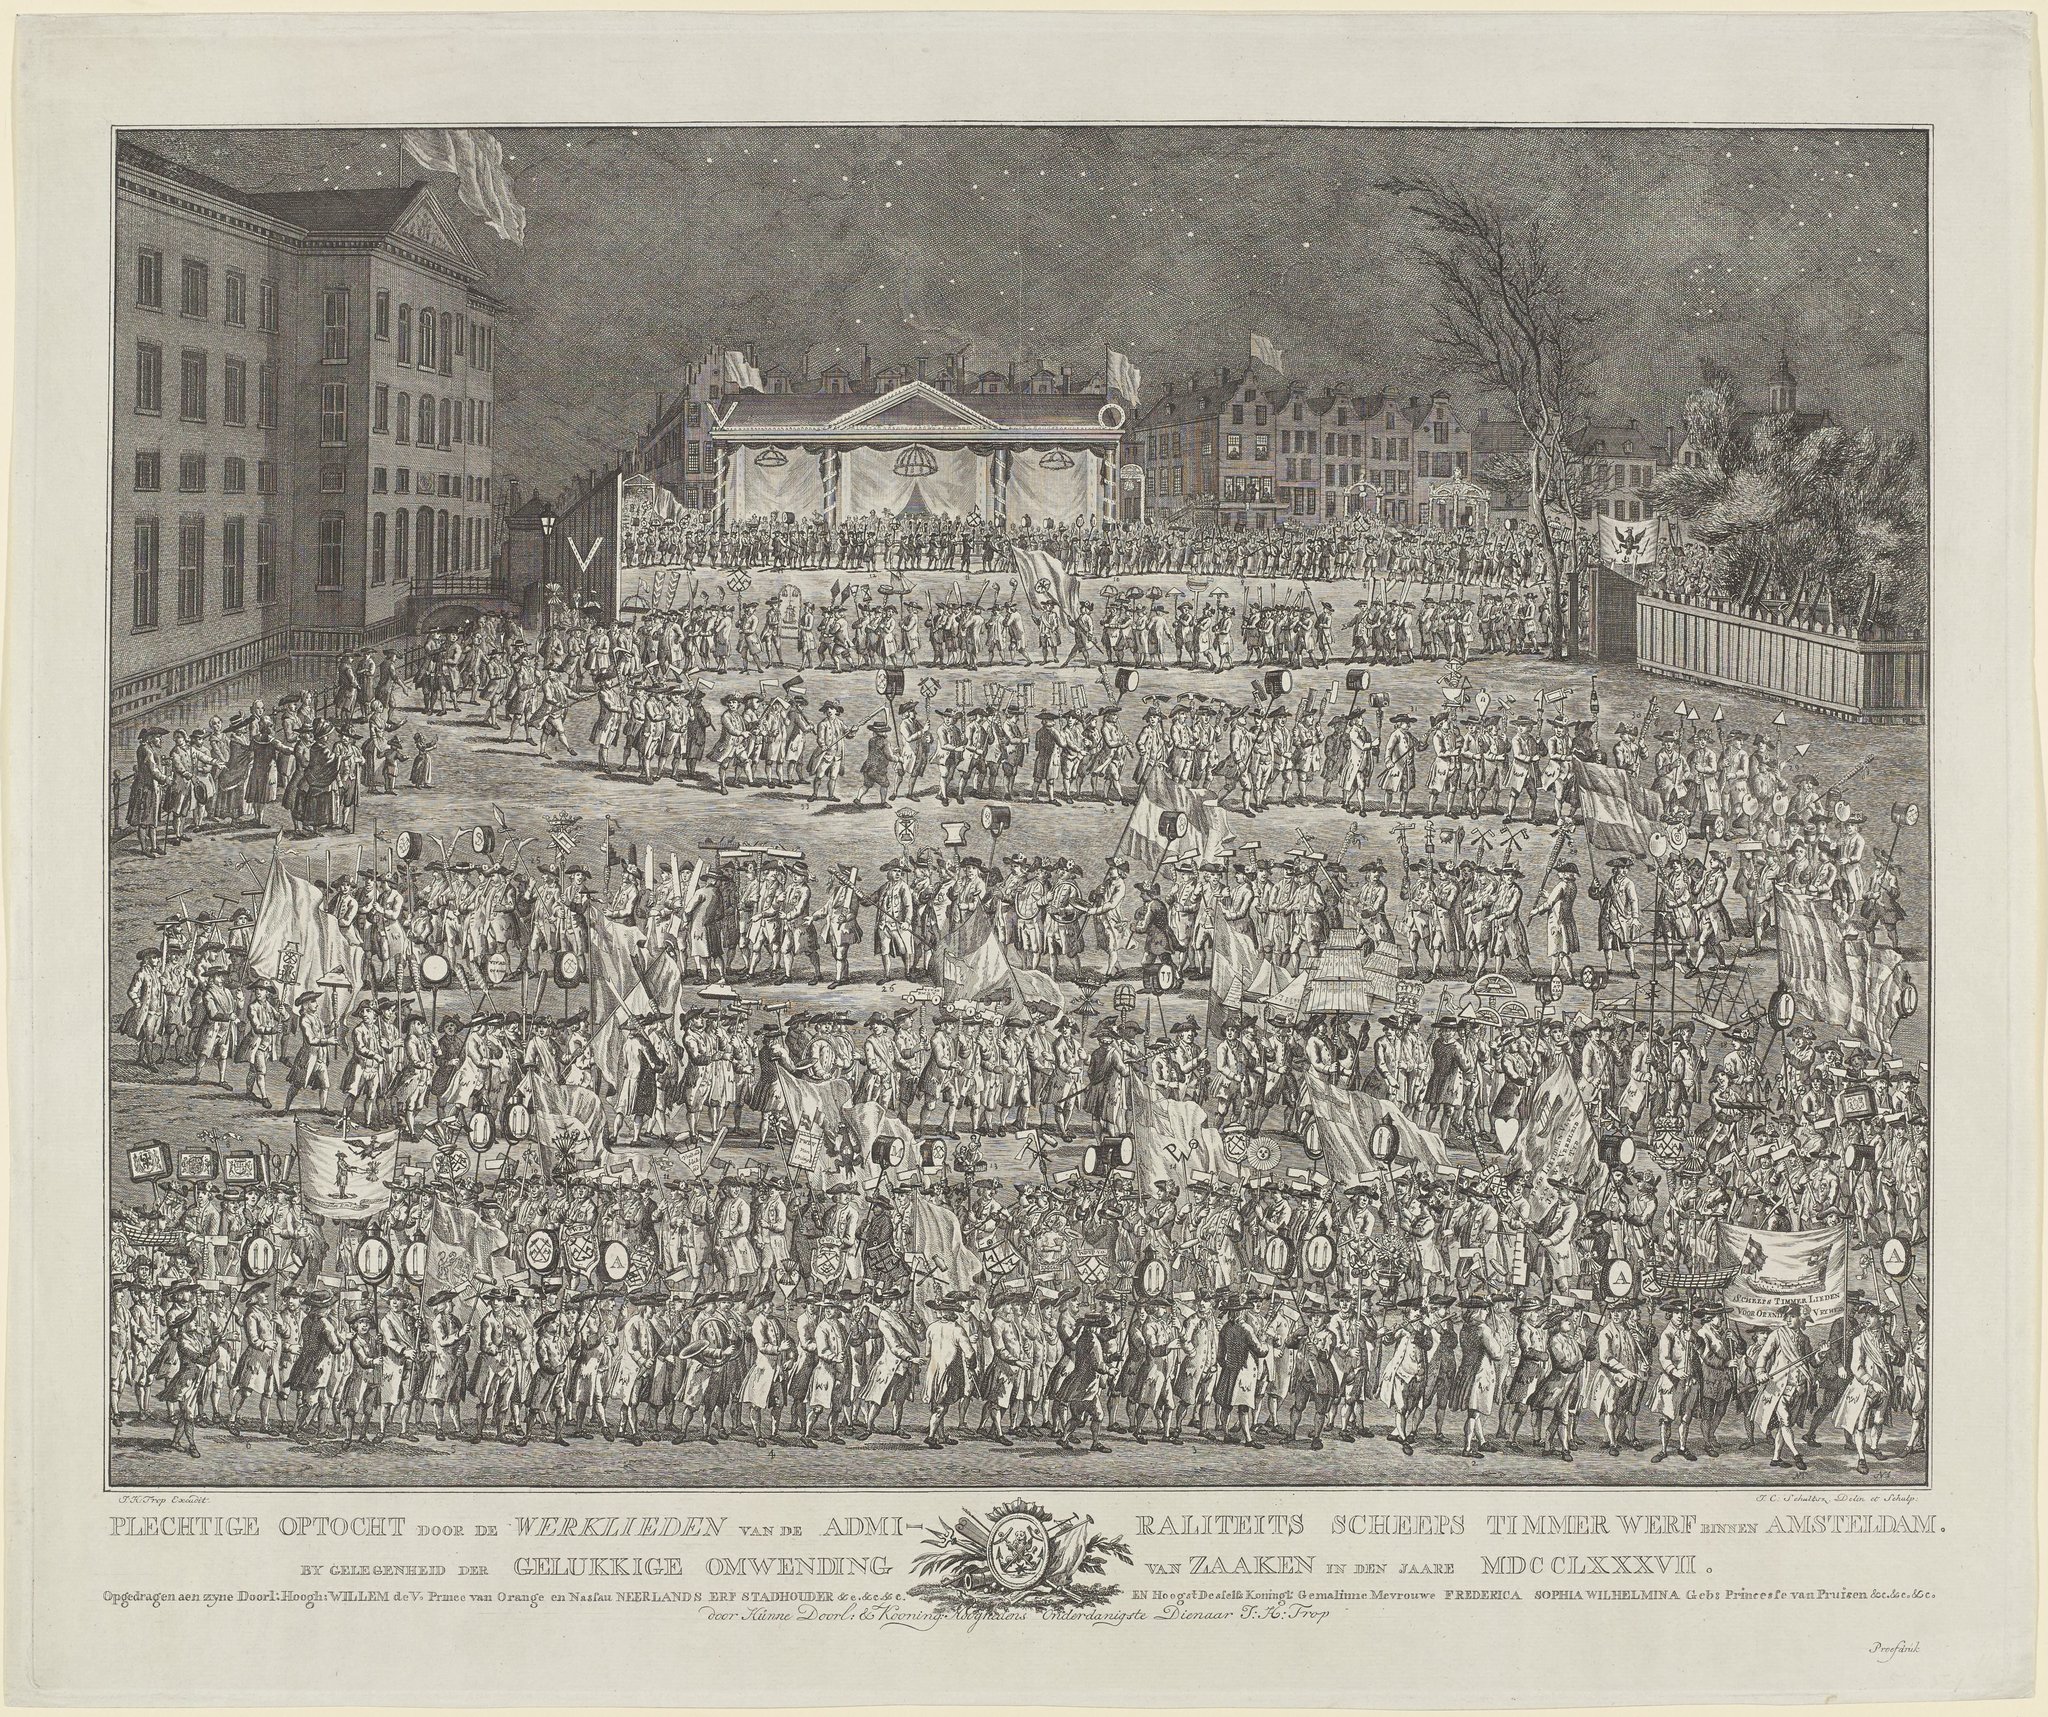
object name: print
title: Drie platen van de optochten van de werklieden in Amsterdam, 1787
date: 1787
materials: paper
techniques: engraving, etching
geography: amsterdam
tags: the hague, william v (prince of orange), pageant of a guild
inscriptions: collector's mark: Lugt 2228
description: Feestelijke optocht in de avond van de Oranjegezinde werklieden van de Admiraliteits Scheepstimmerwerf, in de maanden oktober, november en december 1787. Lange stoet slingert zich over het Kattenburgerplein, links 's Lands Zeemagazijn. De werklieden dragen bijlen en andere werktuigen, borden met de naam van prins Willem V, vlaggen, insignes en symbolen en lantaarns met kaarsen.